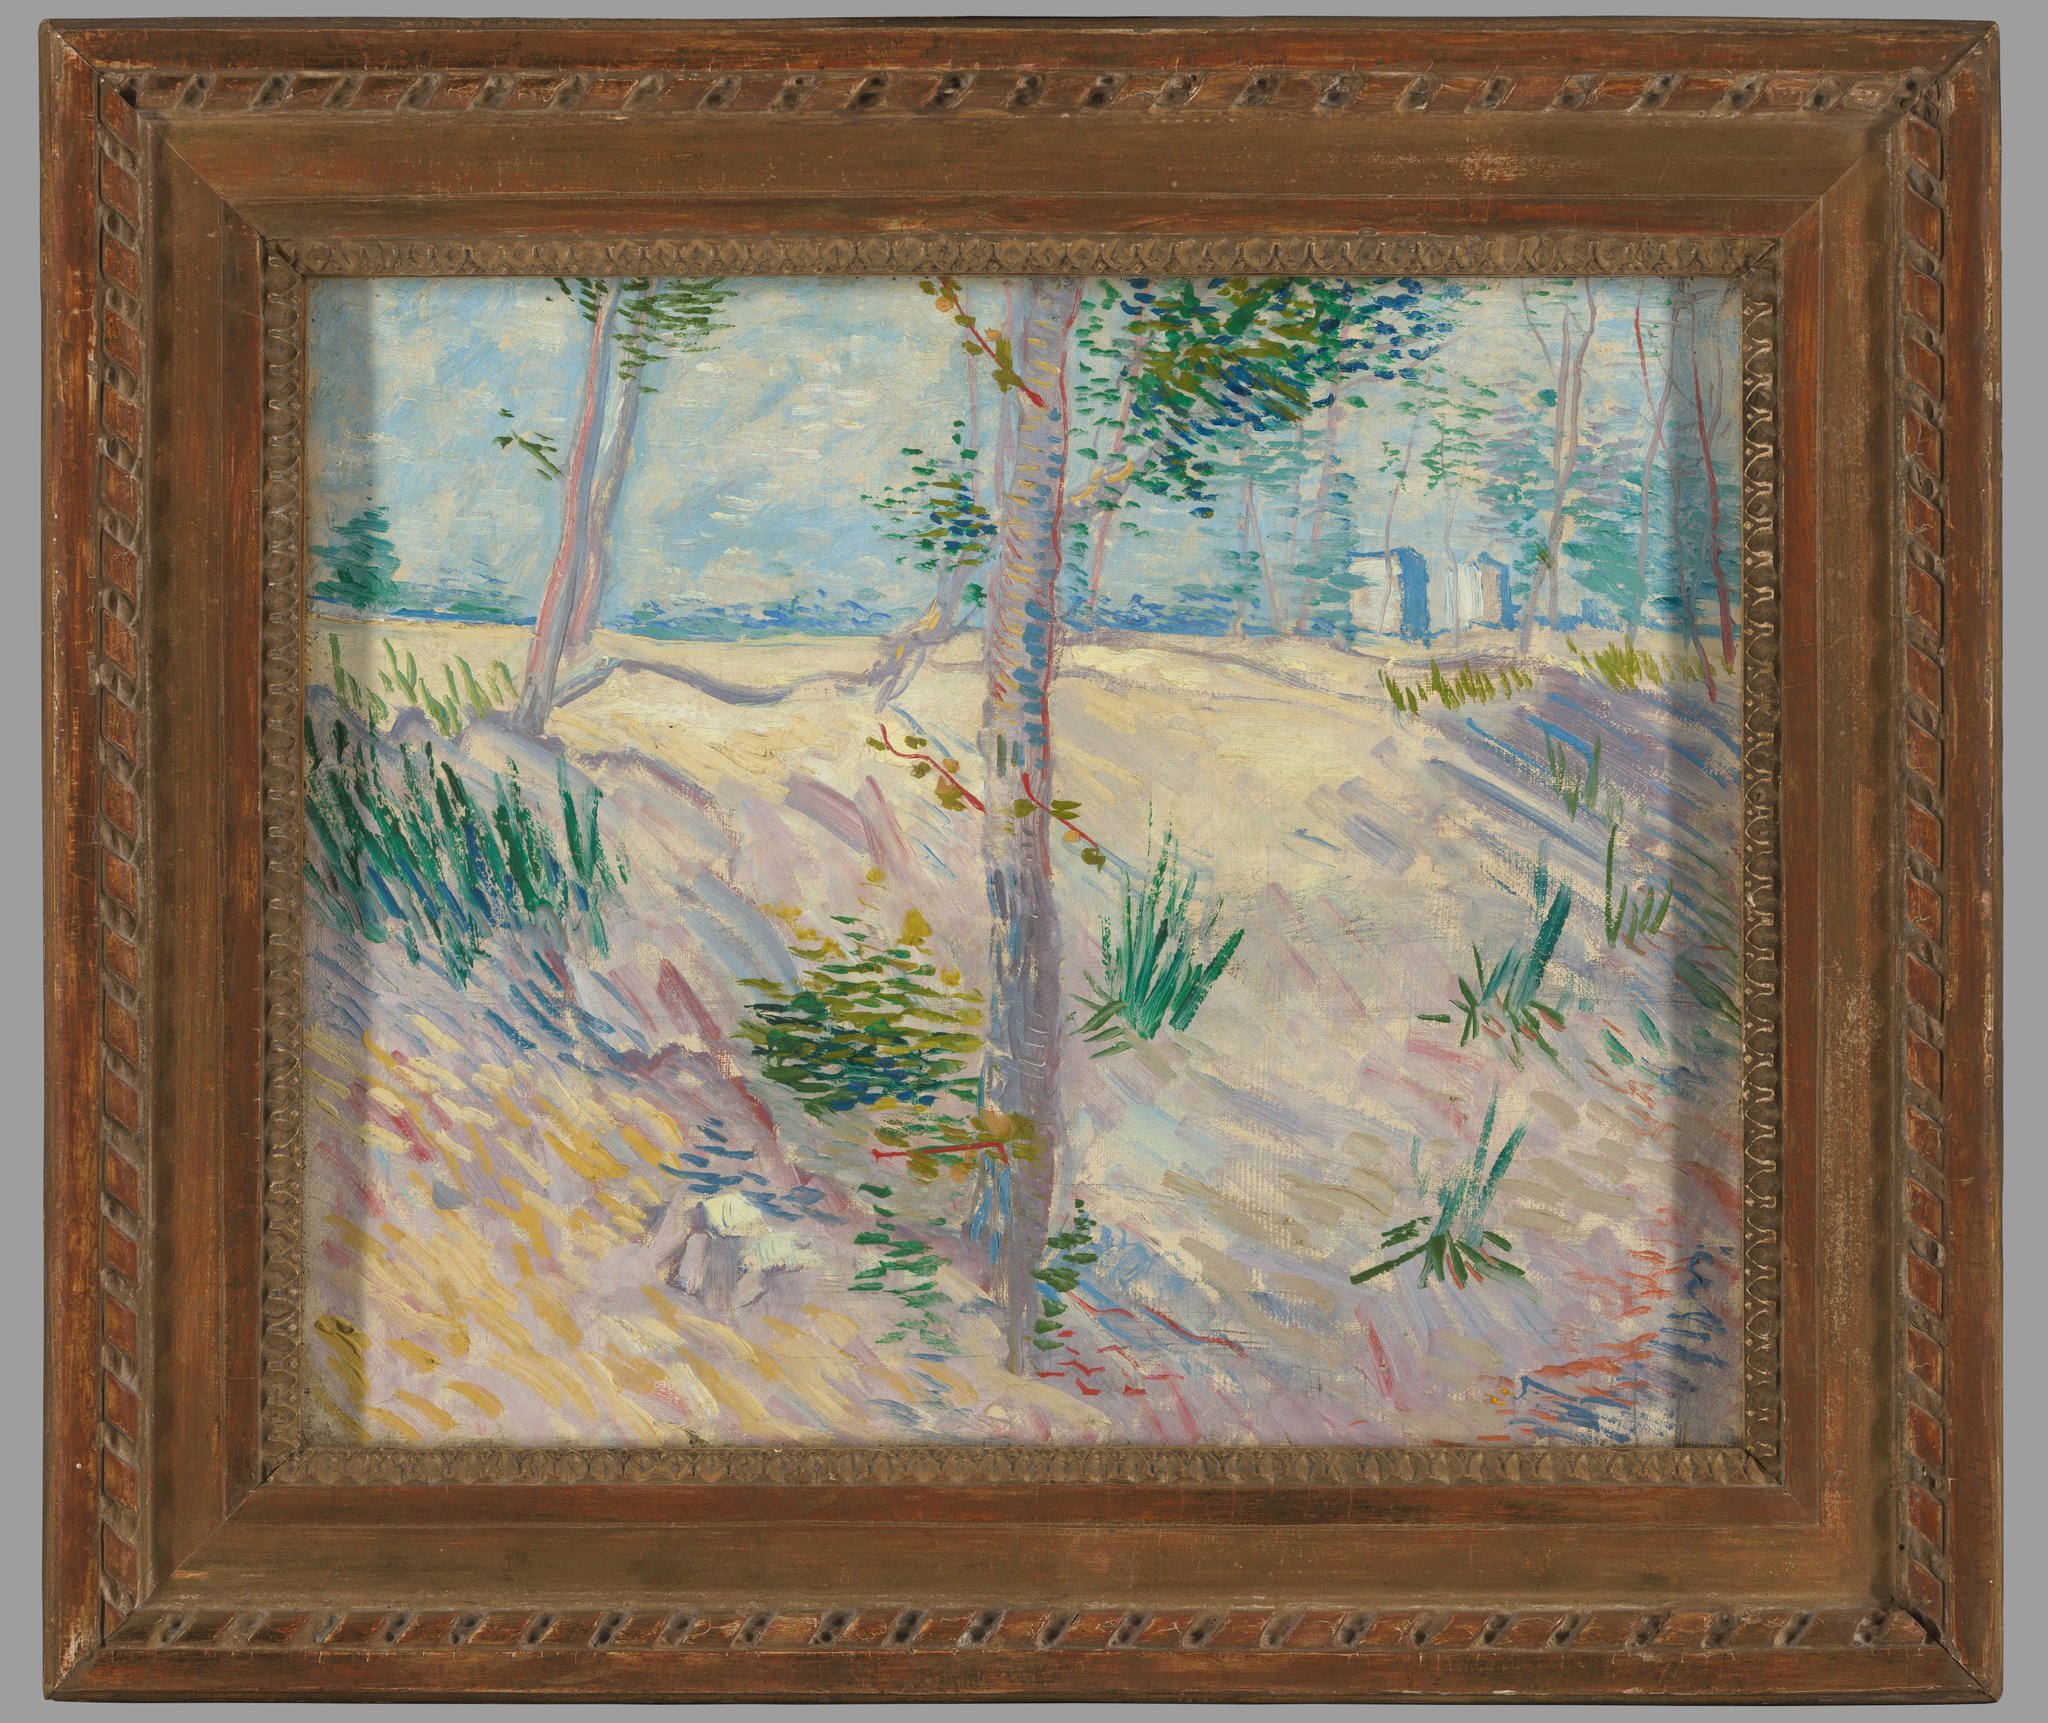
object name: frame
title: Vergulde profiellijst met vlakke bodem en gesneden ornamenten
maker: Anonymous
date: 1800-1900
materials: glass, gold leaf, wood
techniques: cutting, gilding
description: Vergulde profiellijst met vlakke bodem en gesneden ornamenten met lint en bladmotief. Zestiende-eeuws profiel vermaakt voor het schilderij. Hoekverbindingen zijn koud verstekt. In de linkeronderhoek en de rechterbovenhoek restanten van pen-gatverbinding met toogpen/deuvel zichtbaar.